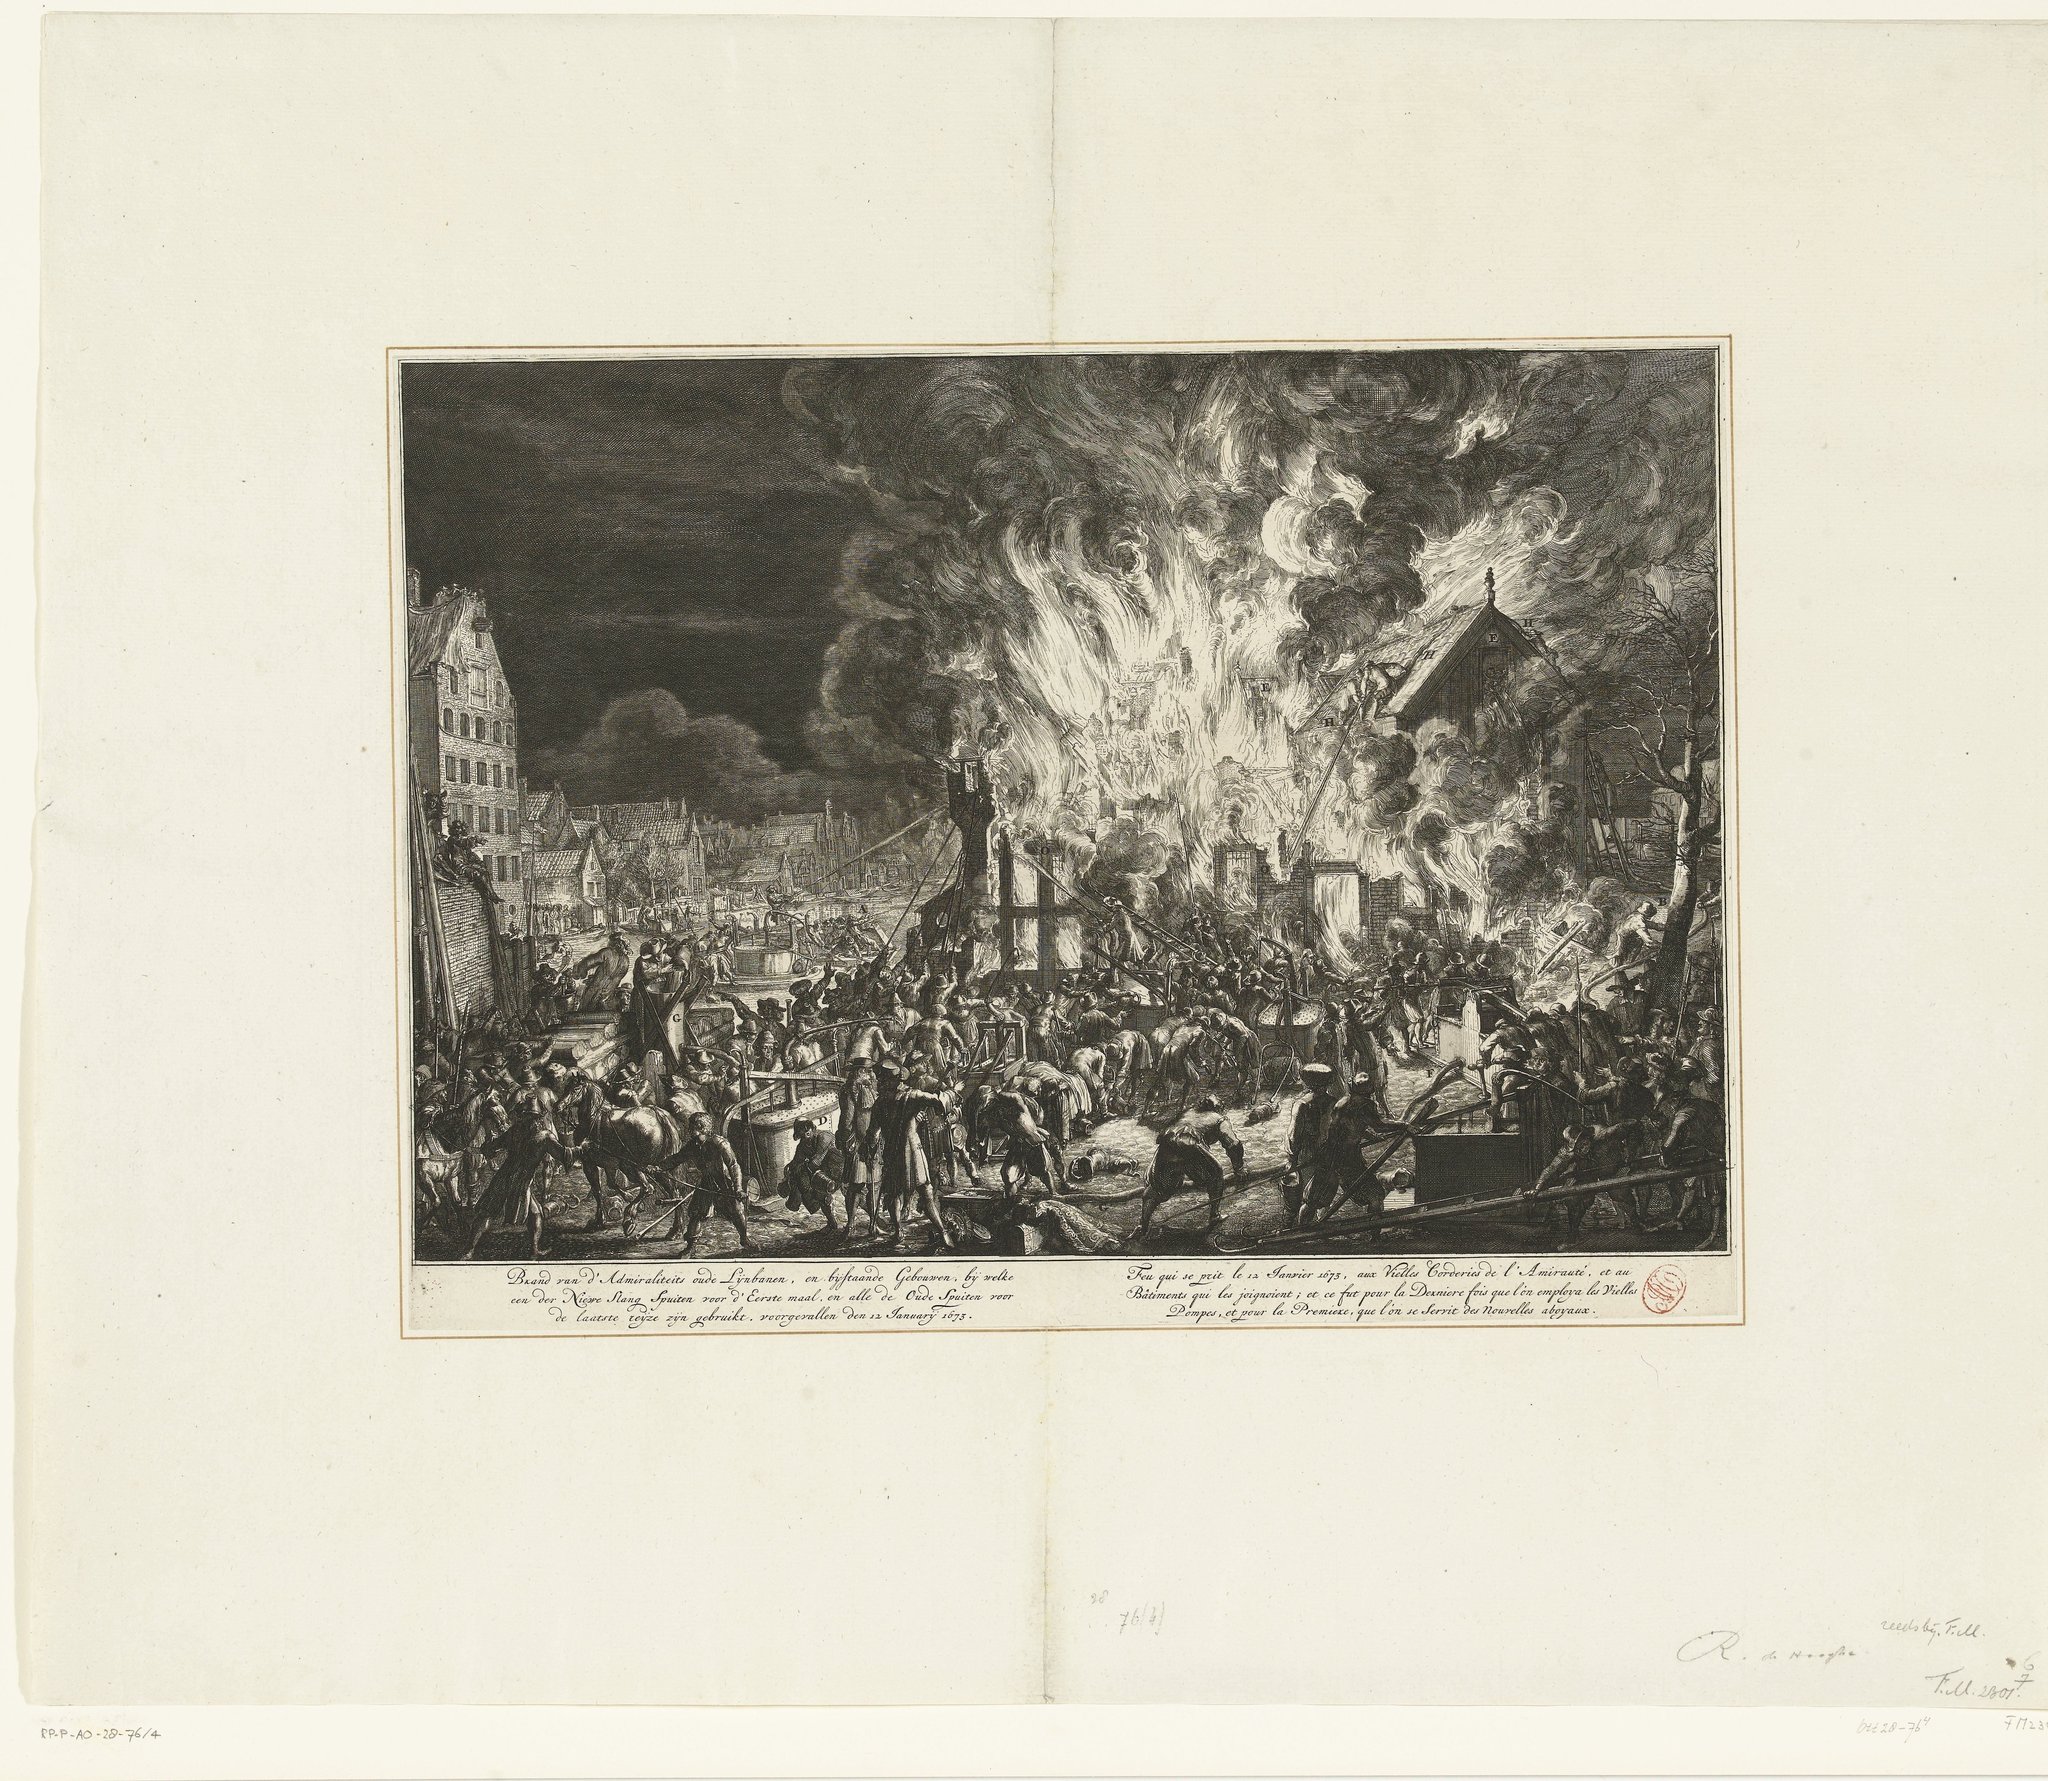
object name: print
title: Brand van d' Admiraliteits oude Lijnbanen, en bijstaande gebouwen (…) voorgevallen den 12 januarij 1673 / Feu qui se prit le 12 janvier 1673, aux vielles Corderies de l' Amirauté, et au bâtiments qui les joignoient (…)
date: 1690-1735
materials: paper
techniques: engraving, etching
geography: northern netherlands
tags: amsterdam, draughtsman, jan van der heyden, on fire, ablaze, fire-fighting, fire-extinguishing equipment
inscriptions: collector's mark: Lugt 195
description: Prent ook gebruikt in: Heyden, Jan van der. Beschryving der nieuwlyks uitgevonden en geoctrojeerde slang-brand-spuiten en haare wyze van brand-blussen, tegenwoordig binnen Amsterdam in gebruik zijnde (…). 1e druk. Amsterdam: Jan Rieuwertsz. (II), 1690. En in: Heyden, Jan van der. Beschryving der nieuwlyks uitgevonden en geoctrojeerde slang-brand-spuiten en haare wyze van brand-blussen, tegenwoordig binnen Amsterdam in gebruik zijnde (…). 2e druk. Amsterdam: erfgenamen Jan van der Heyden, 1735. Voor eerdere staat, voor de letter, zie RP-P-1884-A-7672. Voor andere exemplaren van geletterde staat, zie RP-P-AO-25-61, RP-P-1884-A-7673 en RP-P-OB-77.744.